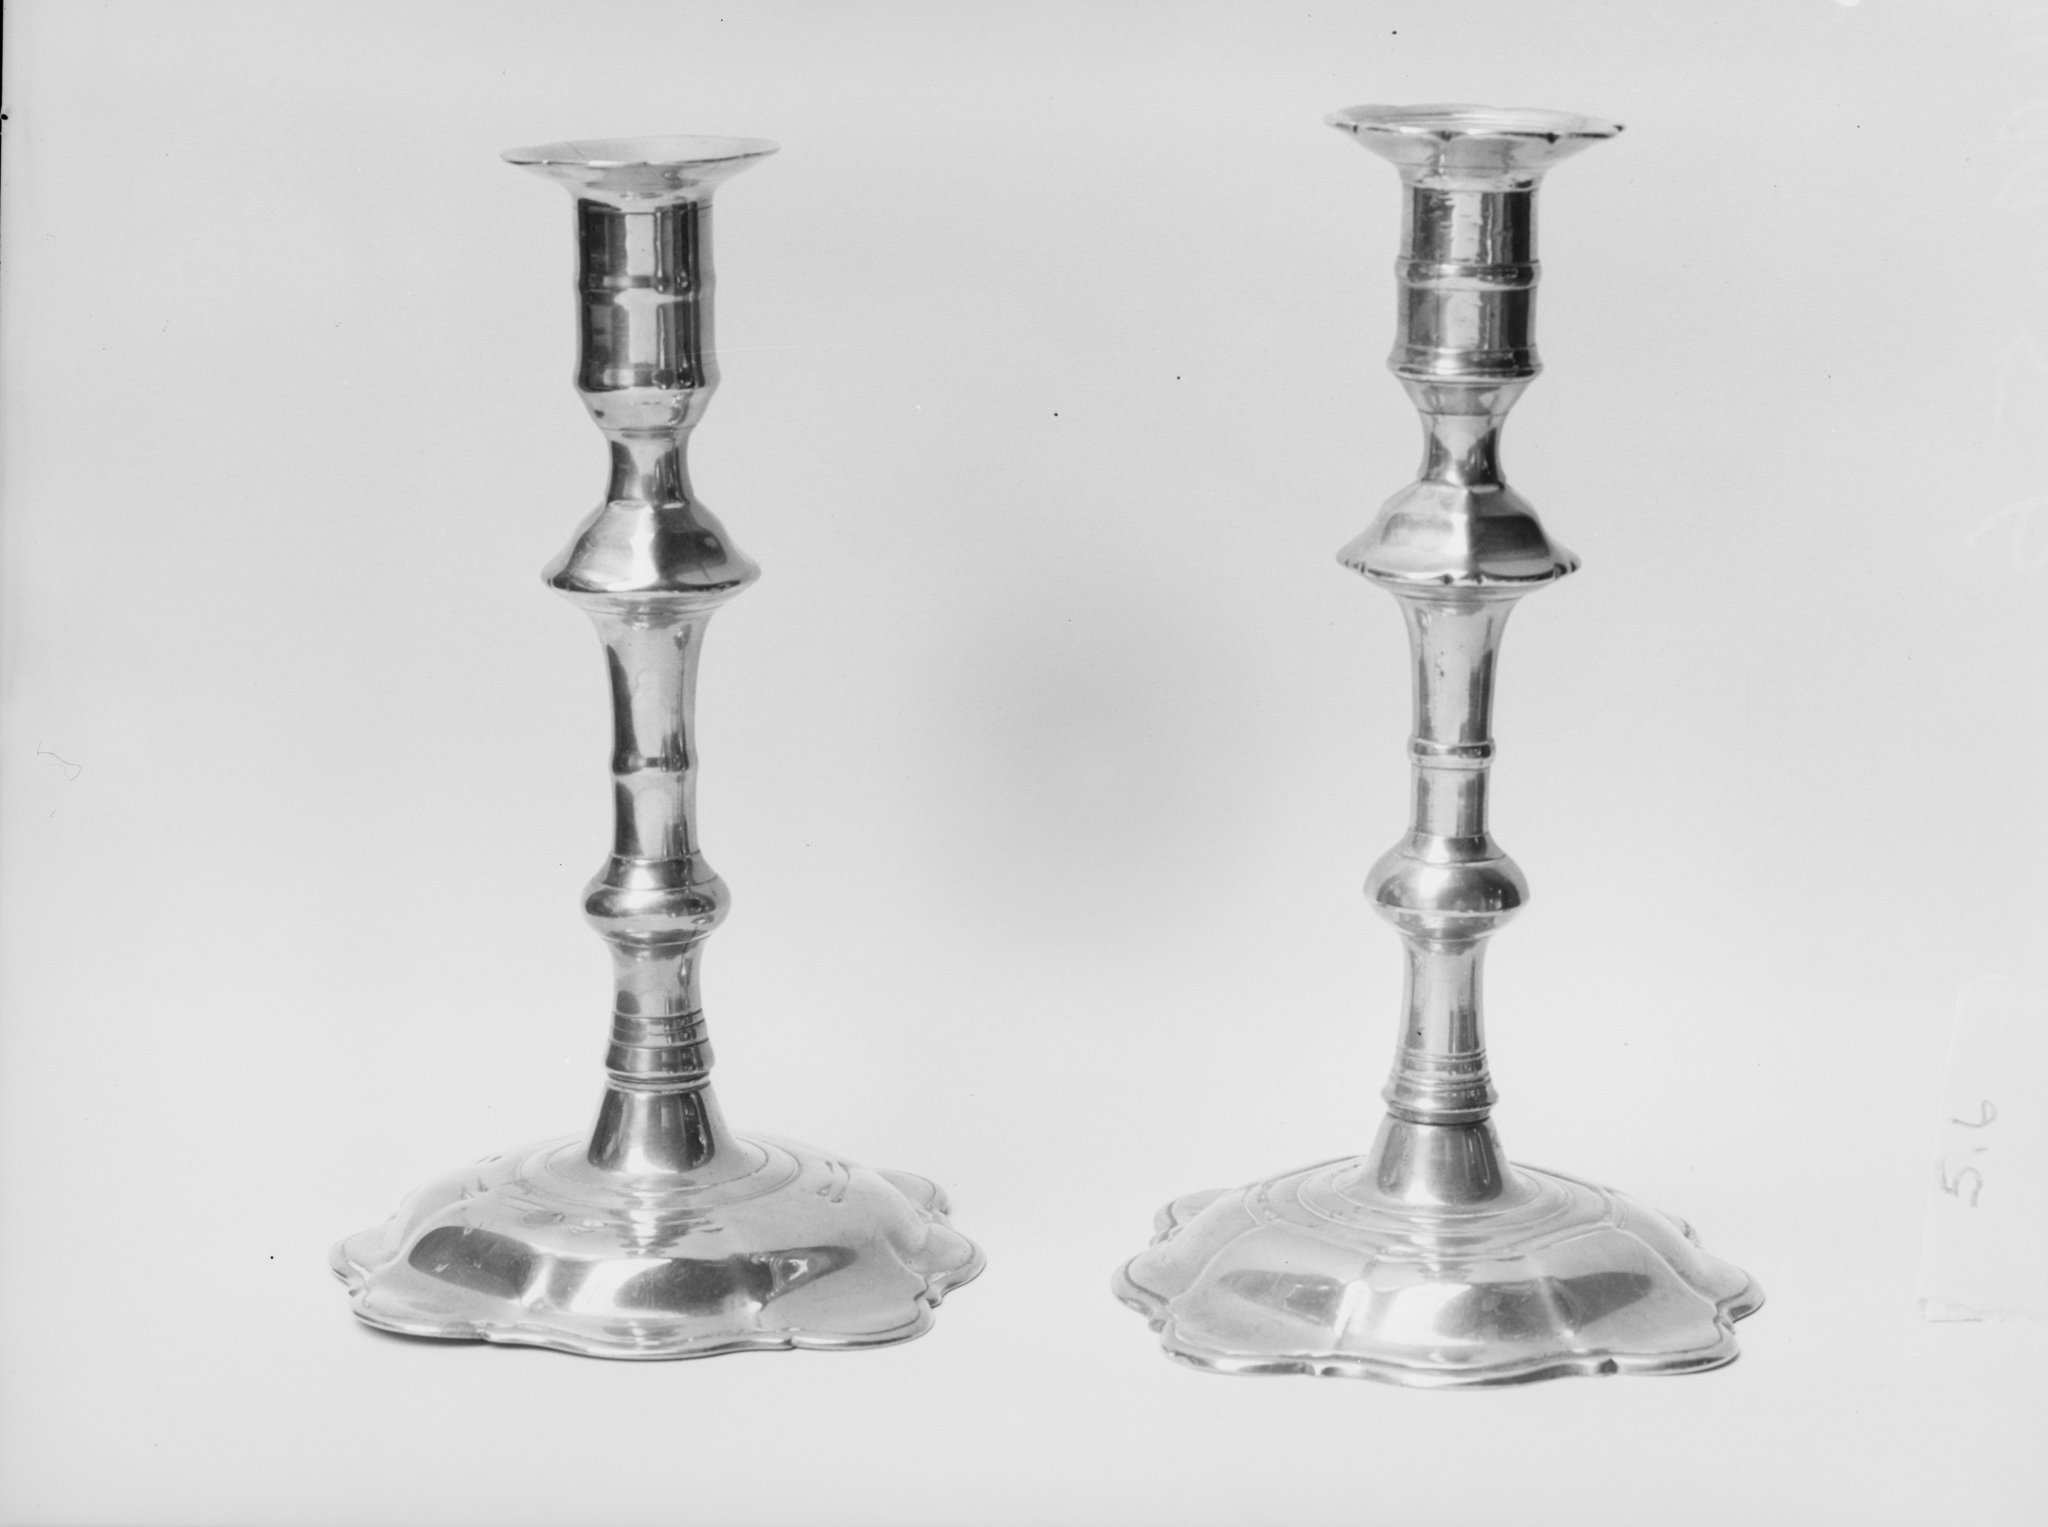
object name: candlestick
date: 1740-1770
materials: brass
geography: england